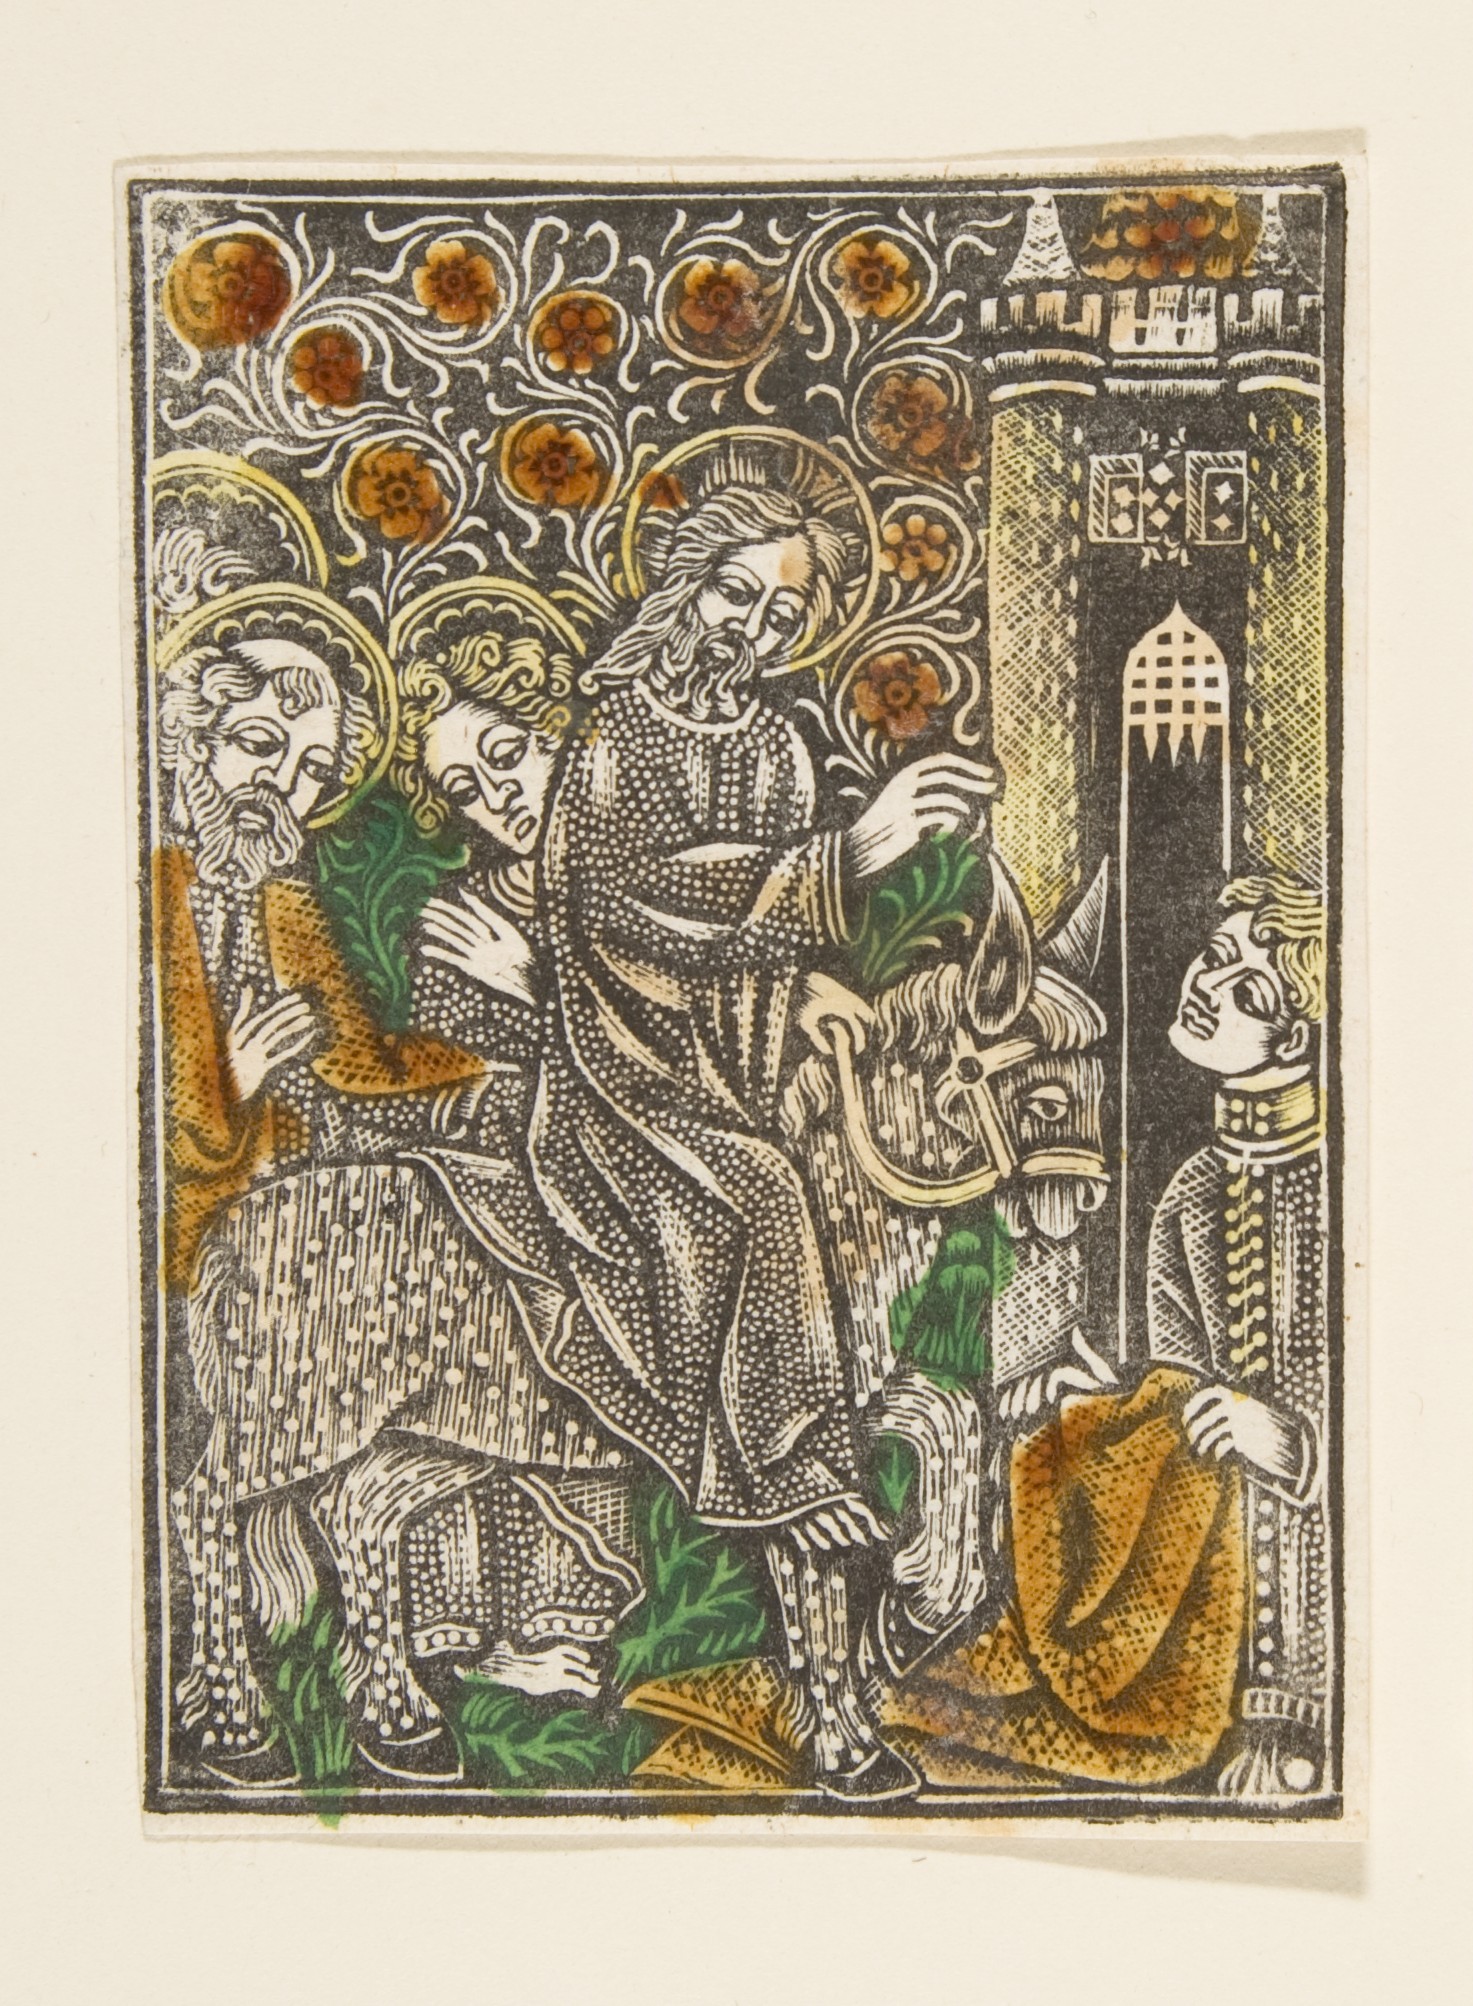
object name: print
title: Christ's Entry into Jerusalem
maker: anonymous, german, 15th century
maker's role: artist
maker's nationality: german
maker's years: 1400-1500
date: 1401-1500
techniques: hand coloring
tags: men,women,horses,flowers,christ